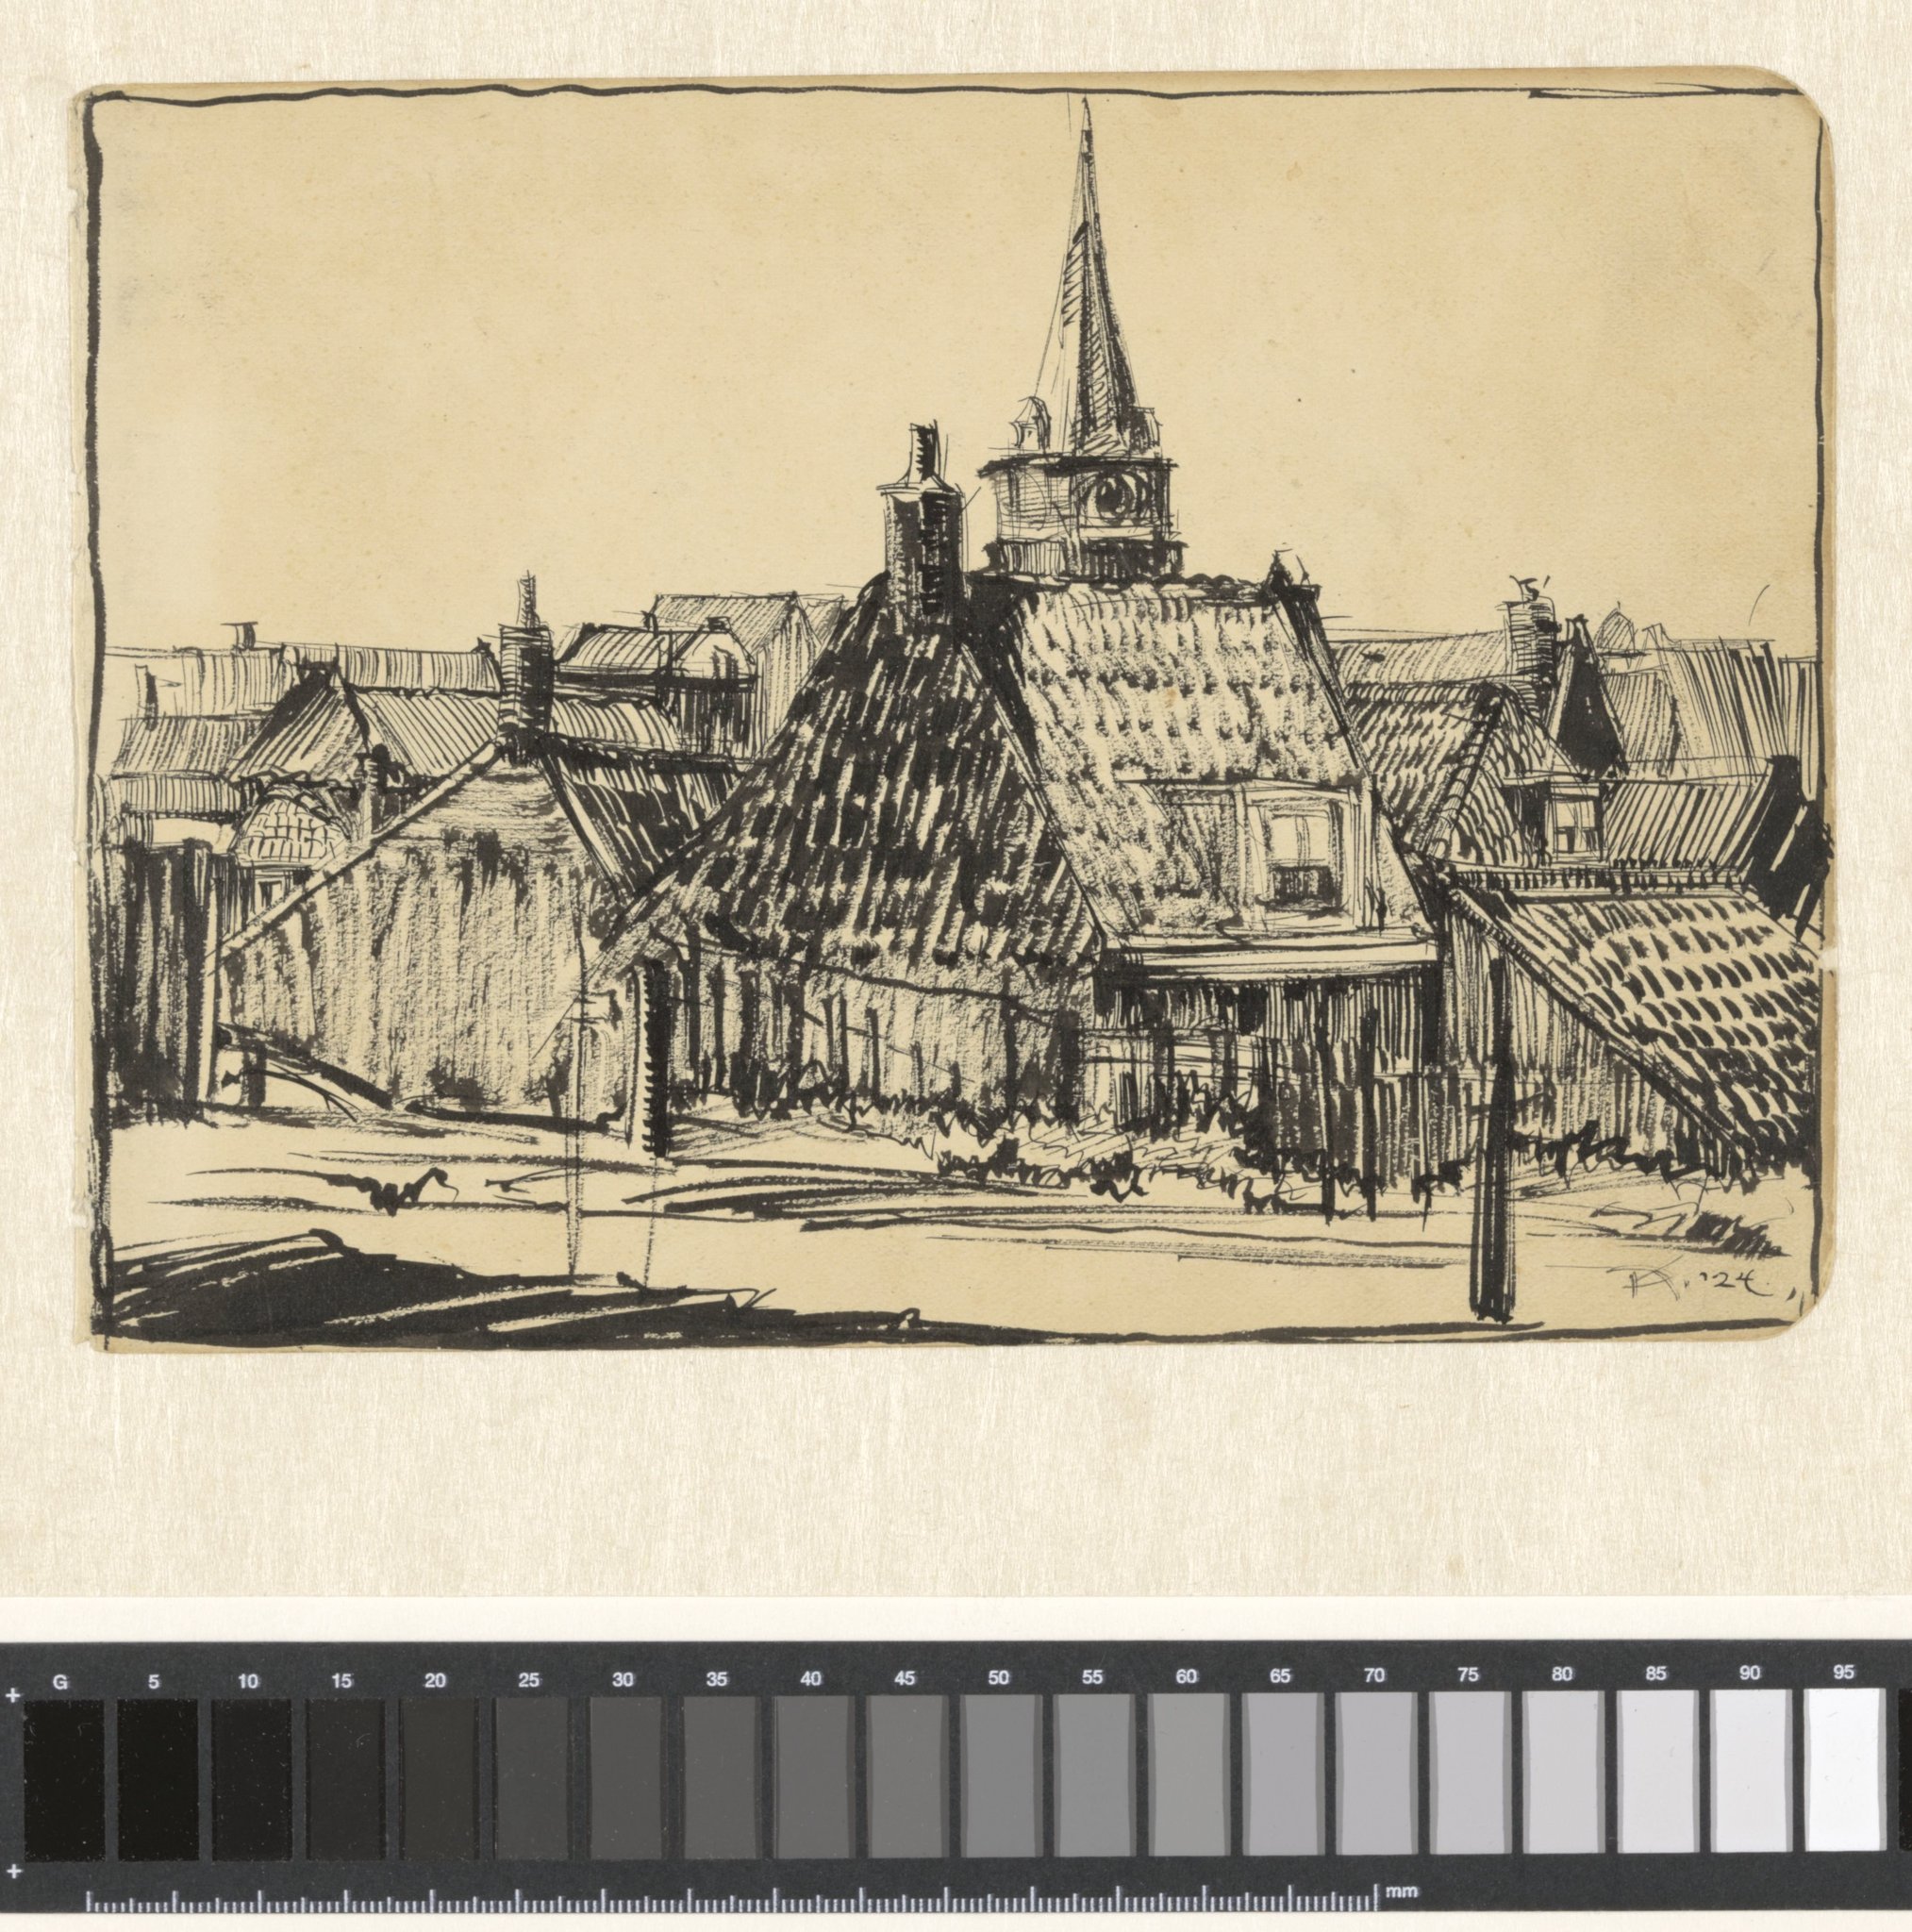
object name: drawing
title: Gezicht op huizen en kerk in Scheveningen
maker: dick ket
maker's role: draughtsman, print maker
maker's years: 1902-1940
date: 1924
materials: ink, paper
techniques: brush, pen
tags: prospect of village, silhouette of village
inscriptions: collector's mark: Lugt 2228